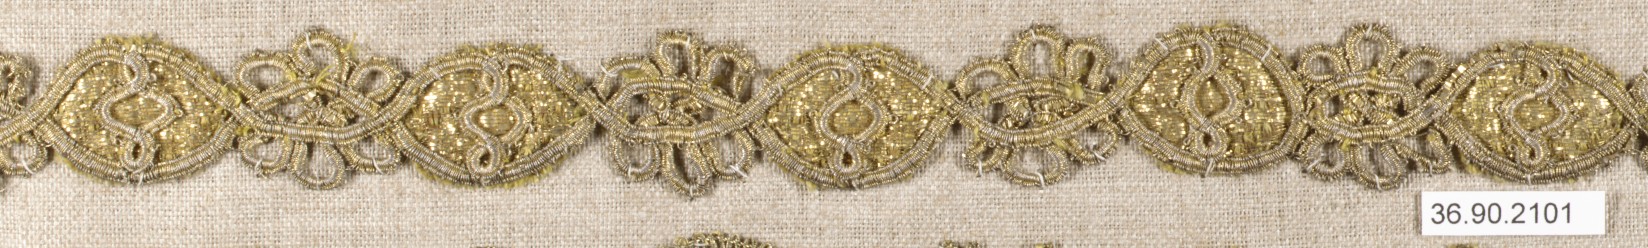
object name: passementerie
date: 1801-1900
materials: metal thread